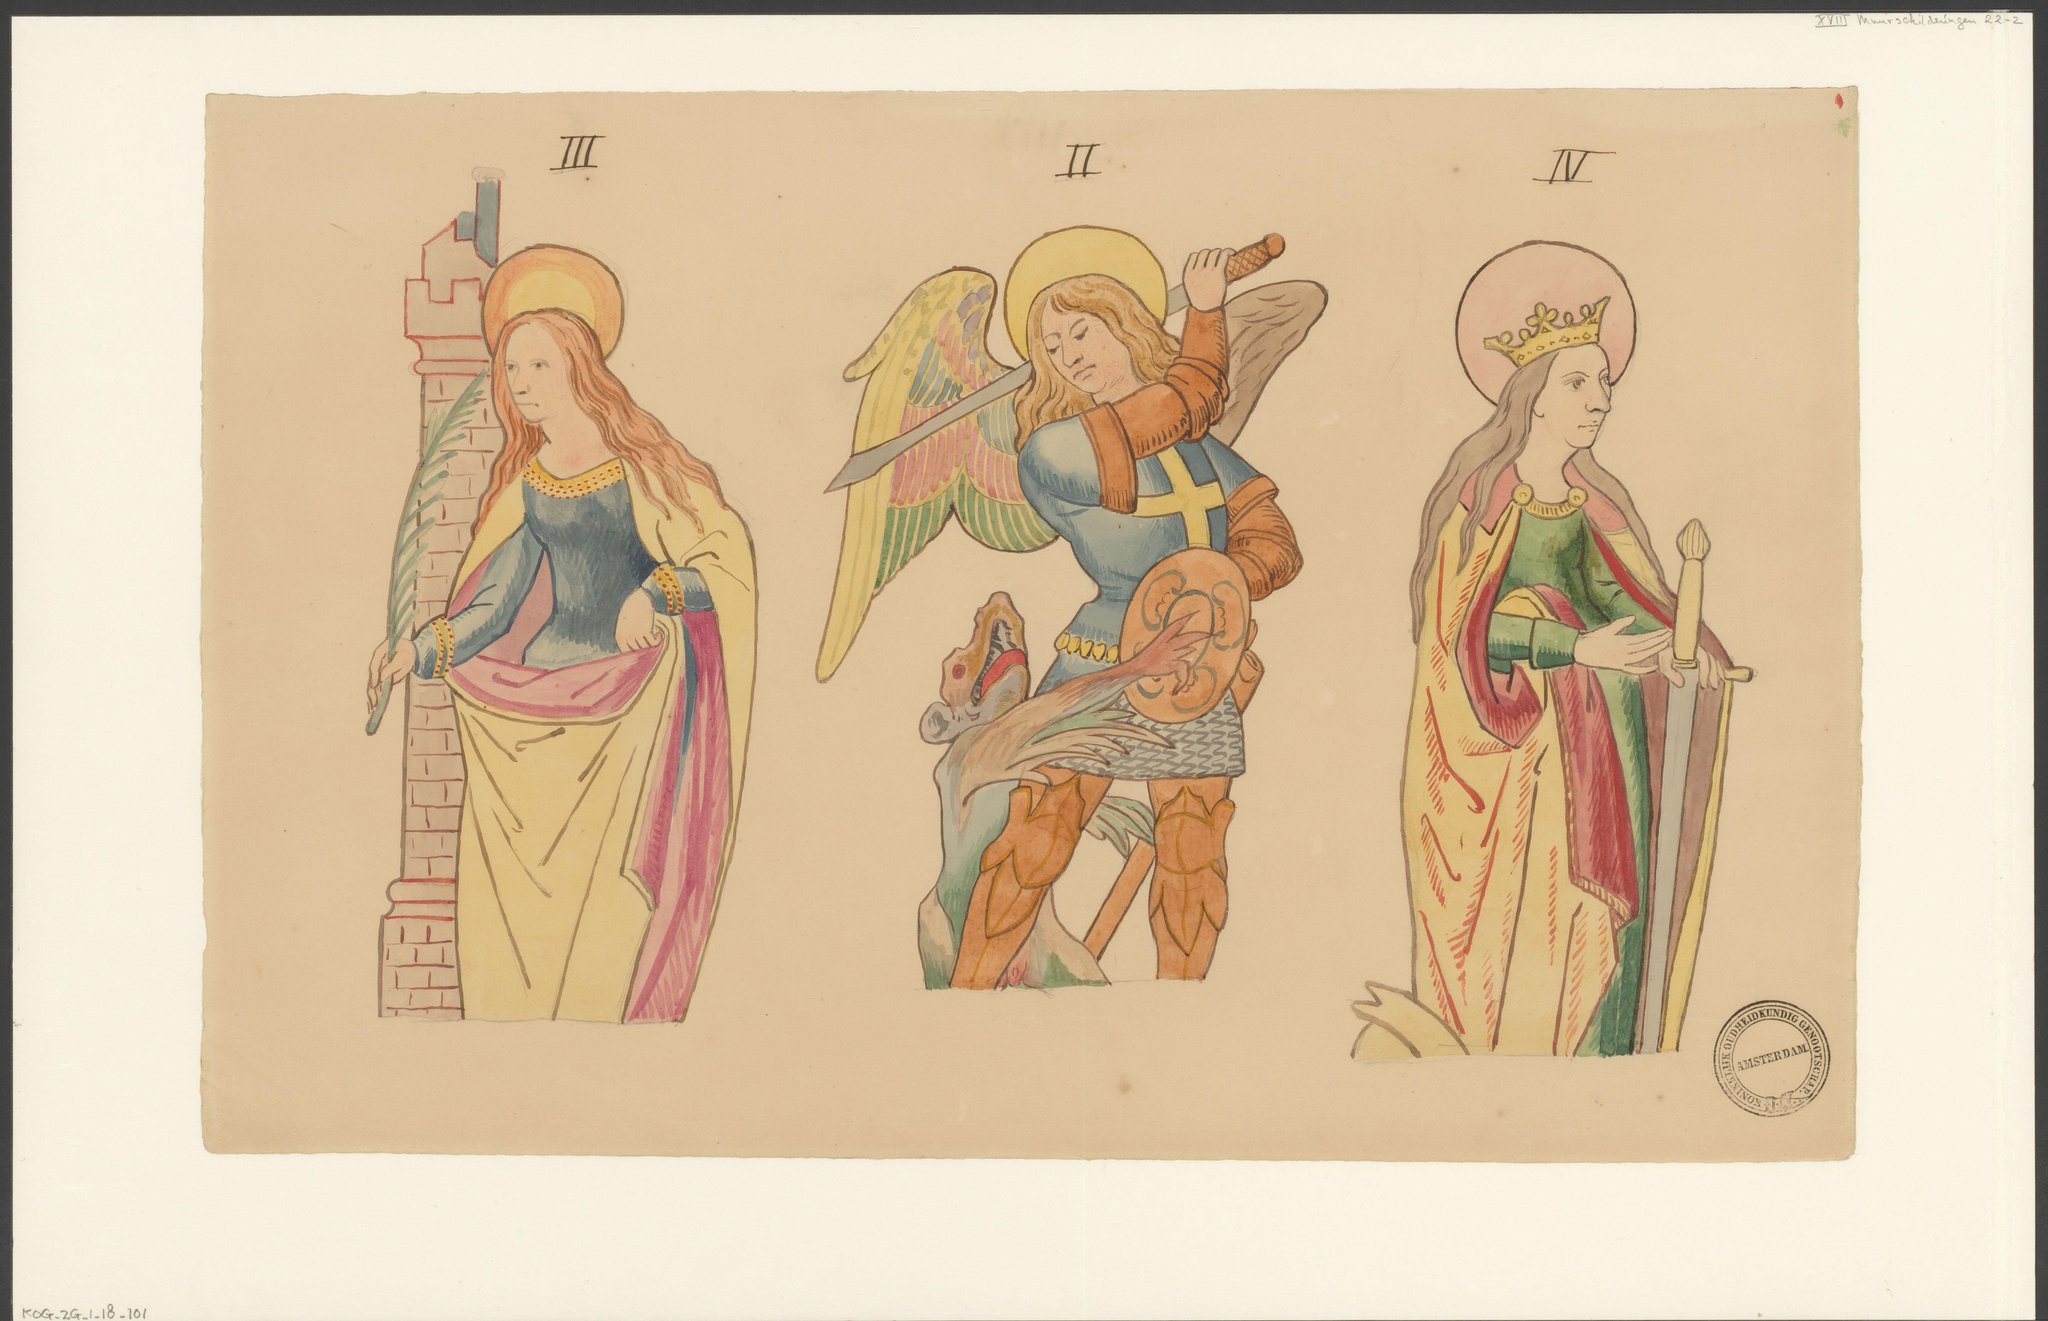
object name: drawing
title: Heilige Barbara, aartsengel Michaël en Heilige Catharina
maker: Anonymous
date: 1850-1949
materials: ink, paper, pencil, watercolor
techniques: brush, pen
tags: the virgin martyr barbara; possible attributes: book, cannon(ball), crown, cross, chalice with wafer, dioscuros (her father), peacock feather, sword, torches, mason's tools, tower, the virgin martyr catherine of alexandria; possible attributes: book, crown, emperor maxentius, palm-branch, ring, sword, wheel, the archangel michael (often in armour with sword or lance)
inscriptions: collector's mark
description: Drie heiligen naast elkaar. Links Heilige Barbara met een palmtak in haar hand en voor een toren. In het midden aartsengel Michaëlaartsengel Michaël in gevecht met een opstandige engel. Rechts Heilige Catharina met een zwaard. Bovenaan genummerd III, II, IV. Waarschijnlijk getekend naar gebrandschilderd glas. Onderwerpsrubrieken binnen de Atlas Zeden en Gewoonten: Schoone kunsten, Muur- en gewelfschilderingen.